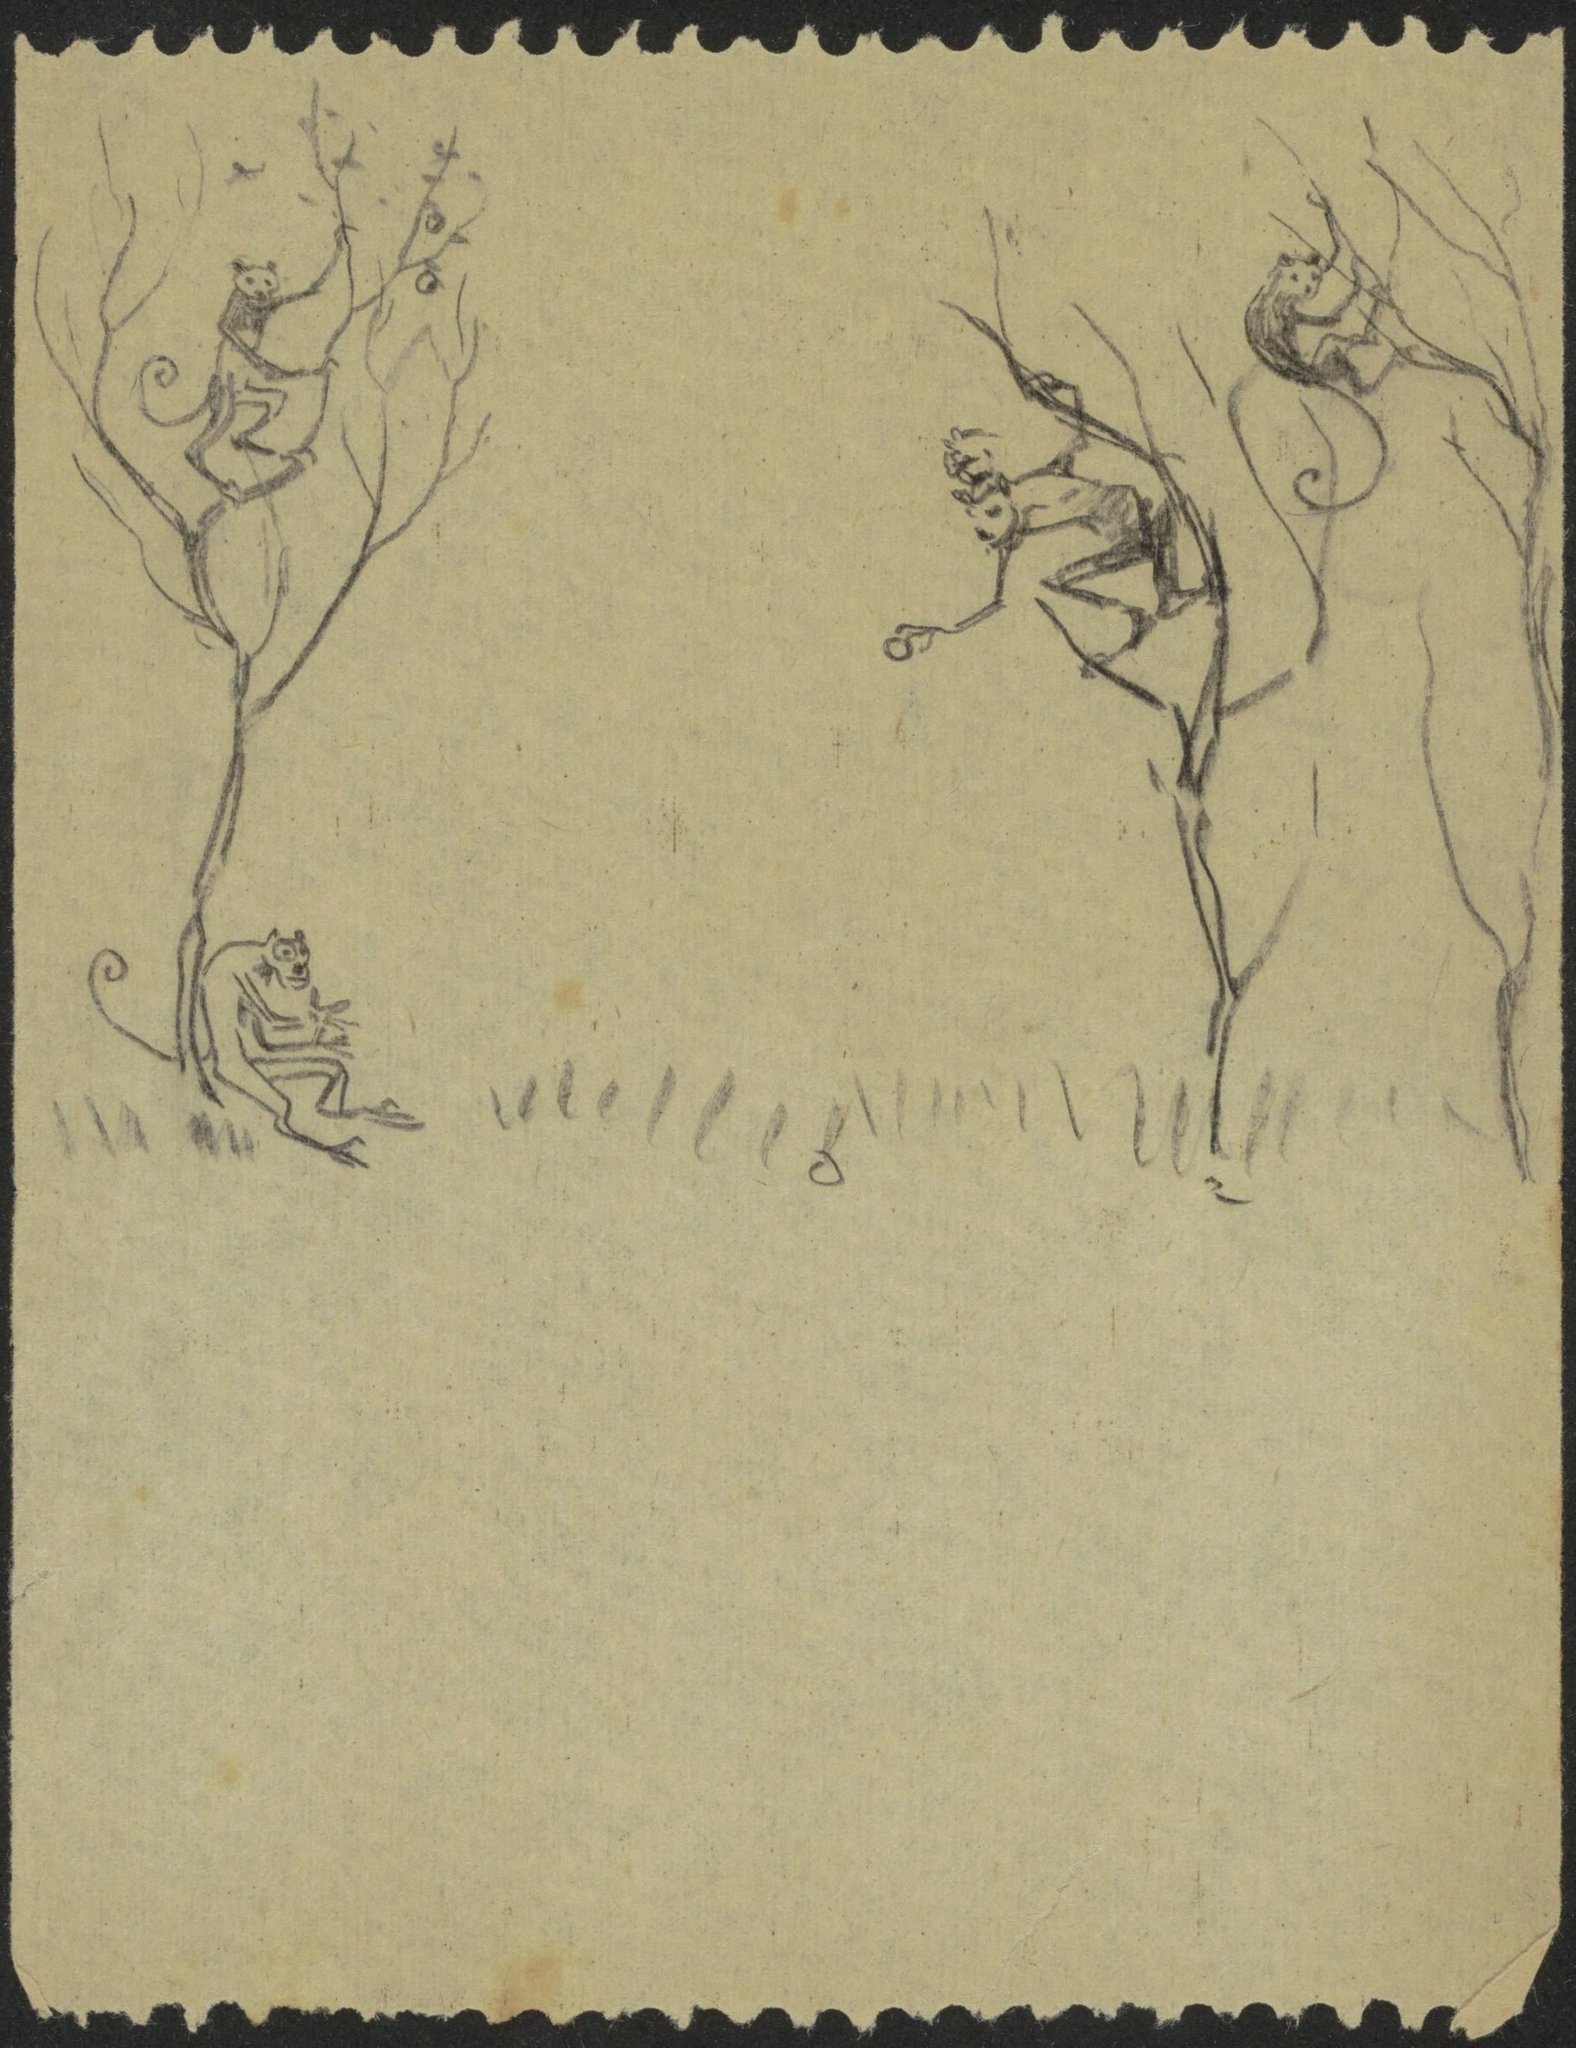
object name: drawing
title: Apen in bomen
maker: gerrit willem dijsselhof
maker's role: designer, draughtsman, print maker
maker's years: 1866-1924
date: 1904-1906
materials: chalk, paper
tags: monkeys, apes